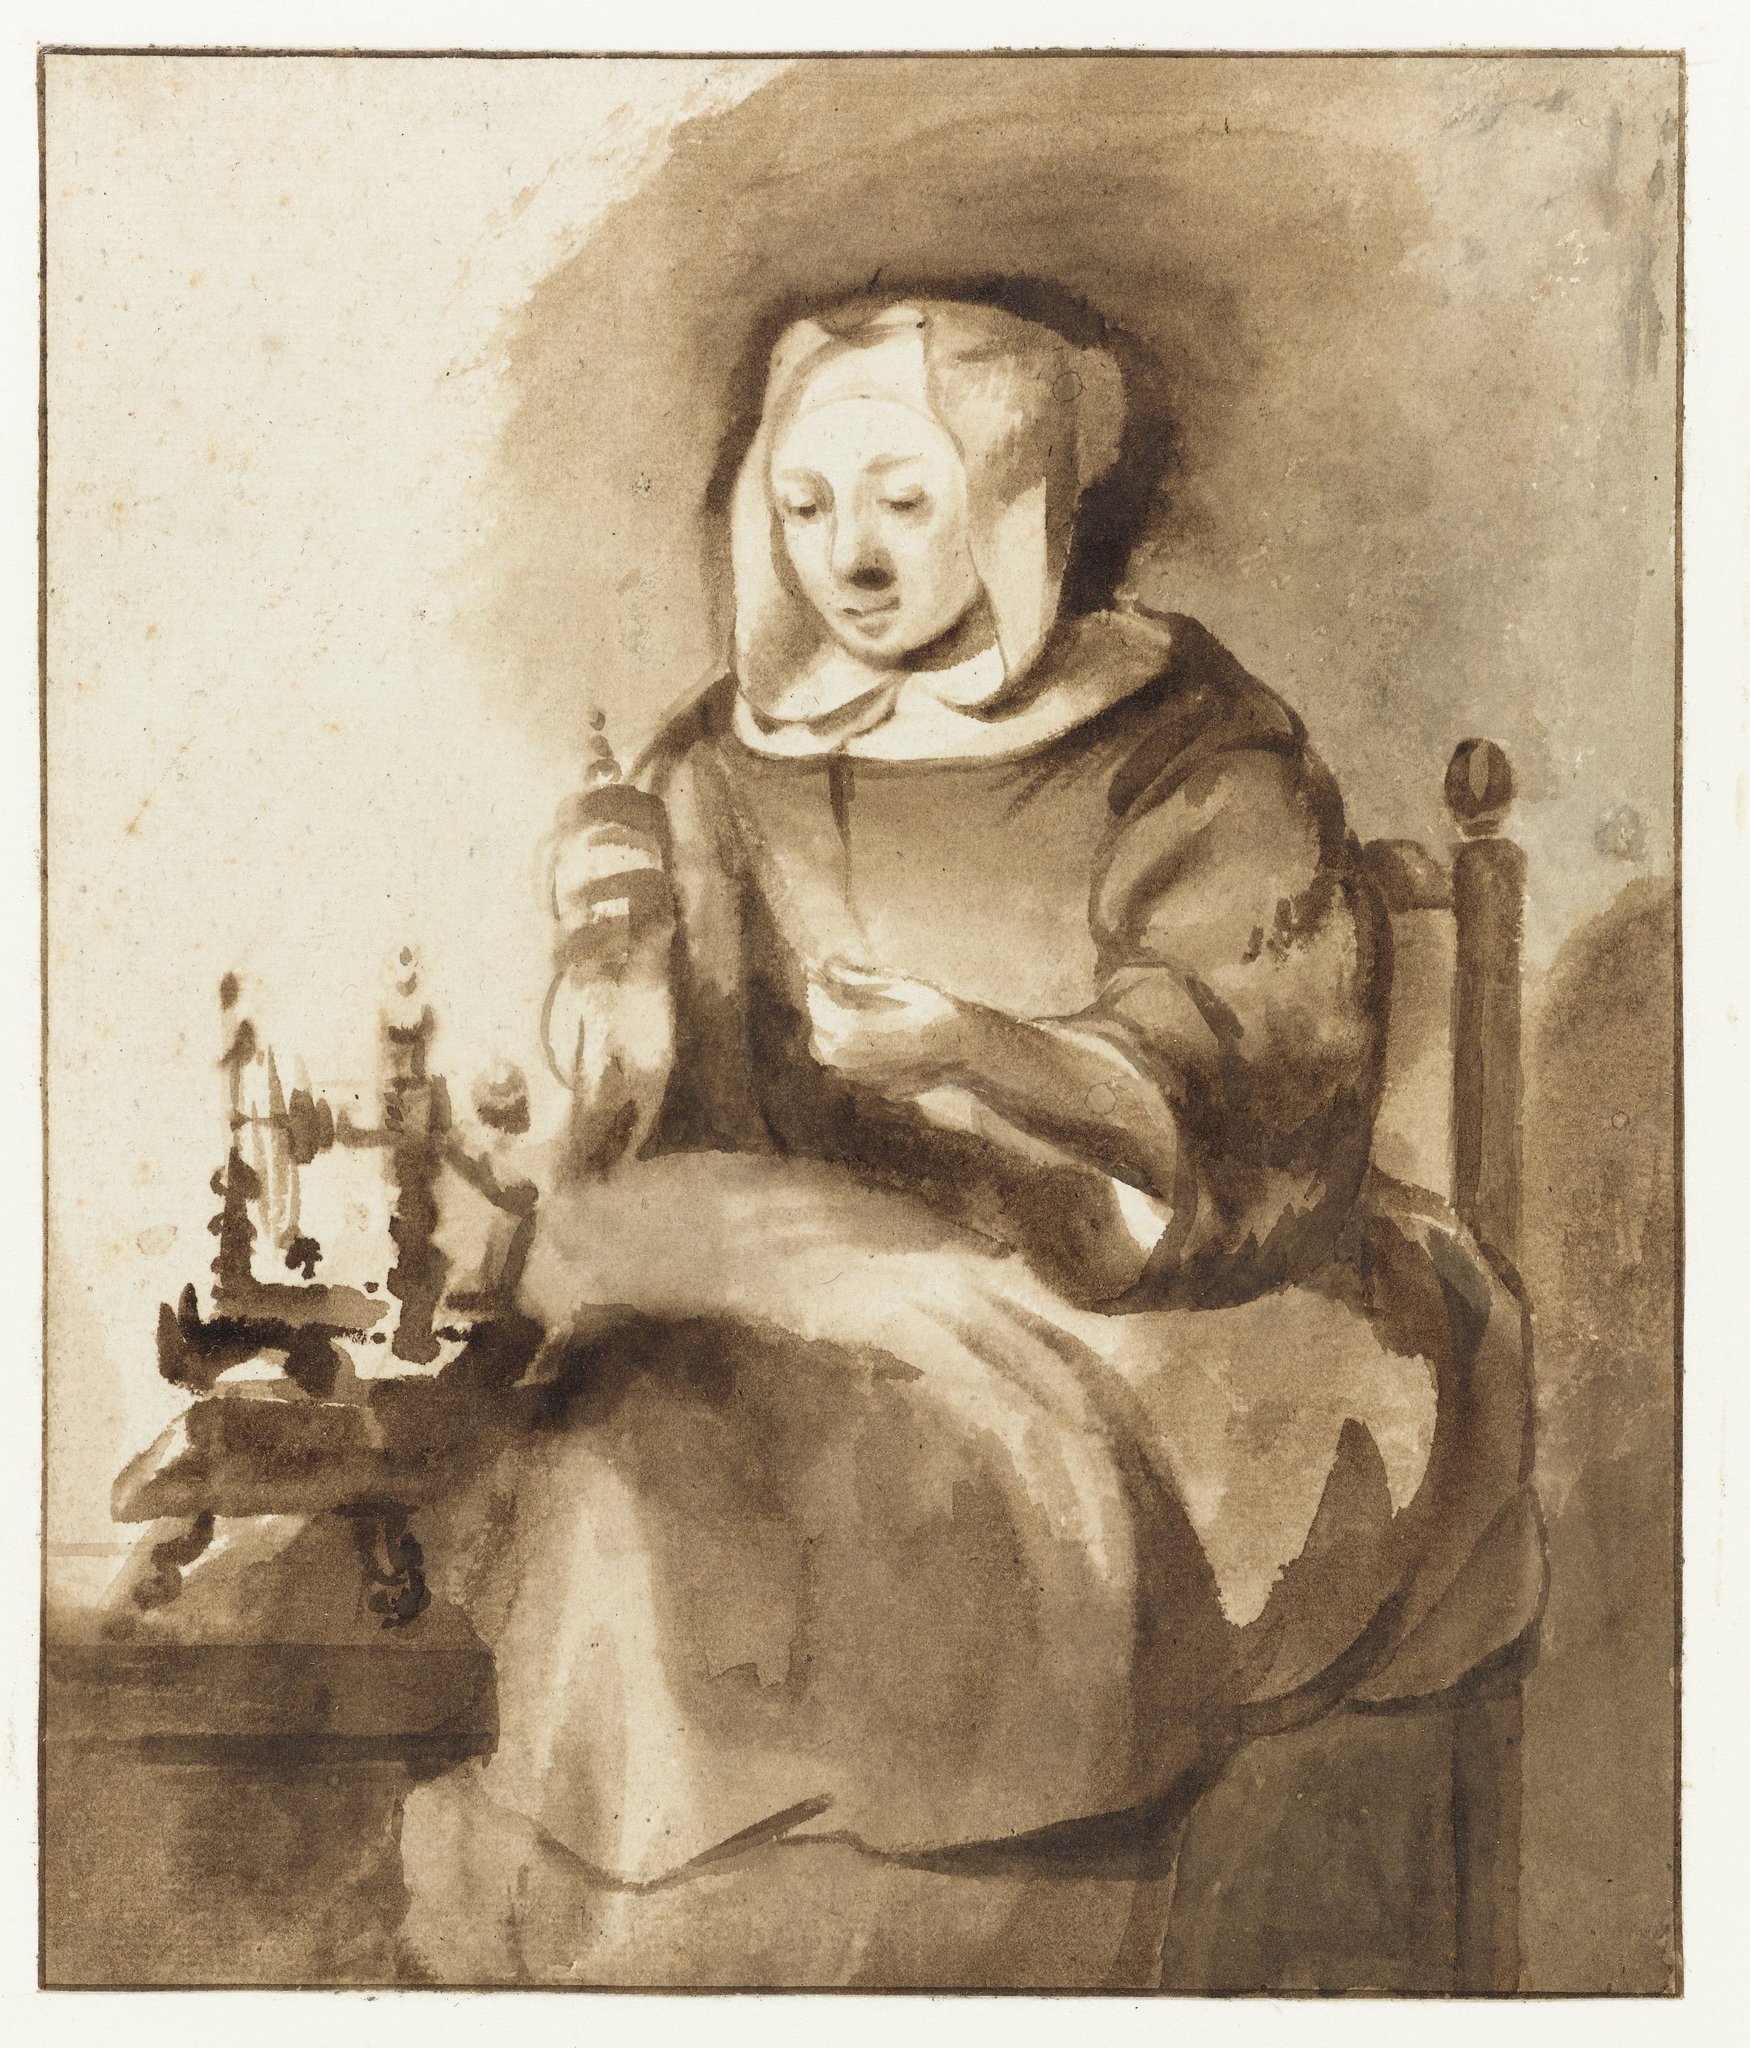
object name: drawing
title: Woman spinning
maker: gerbrand van den eeckhout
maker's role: draughtsman, print maker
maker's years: 1621-1674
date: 1653-1657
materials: paper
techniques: brush